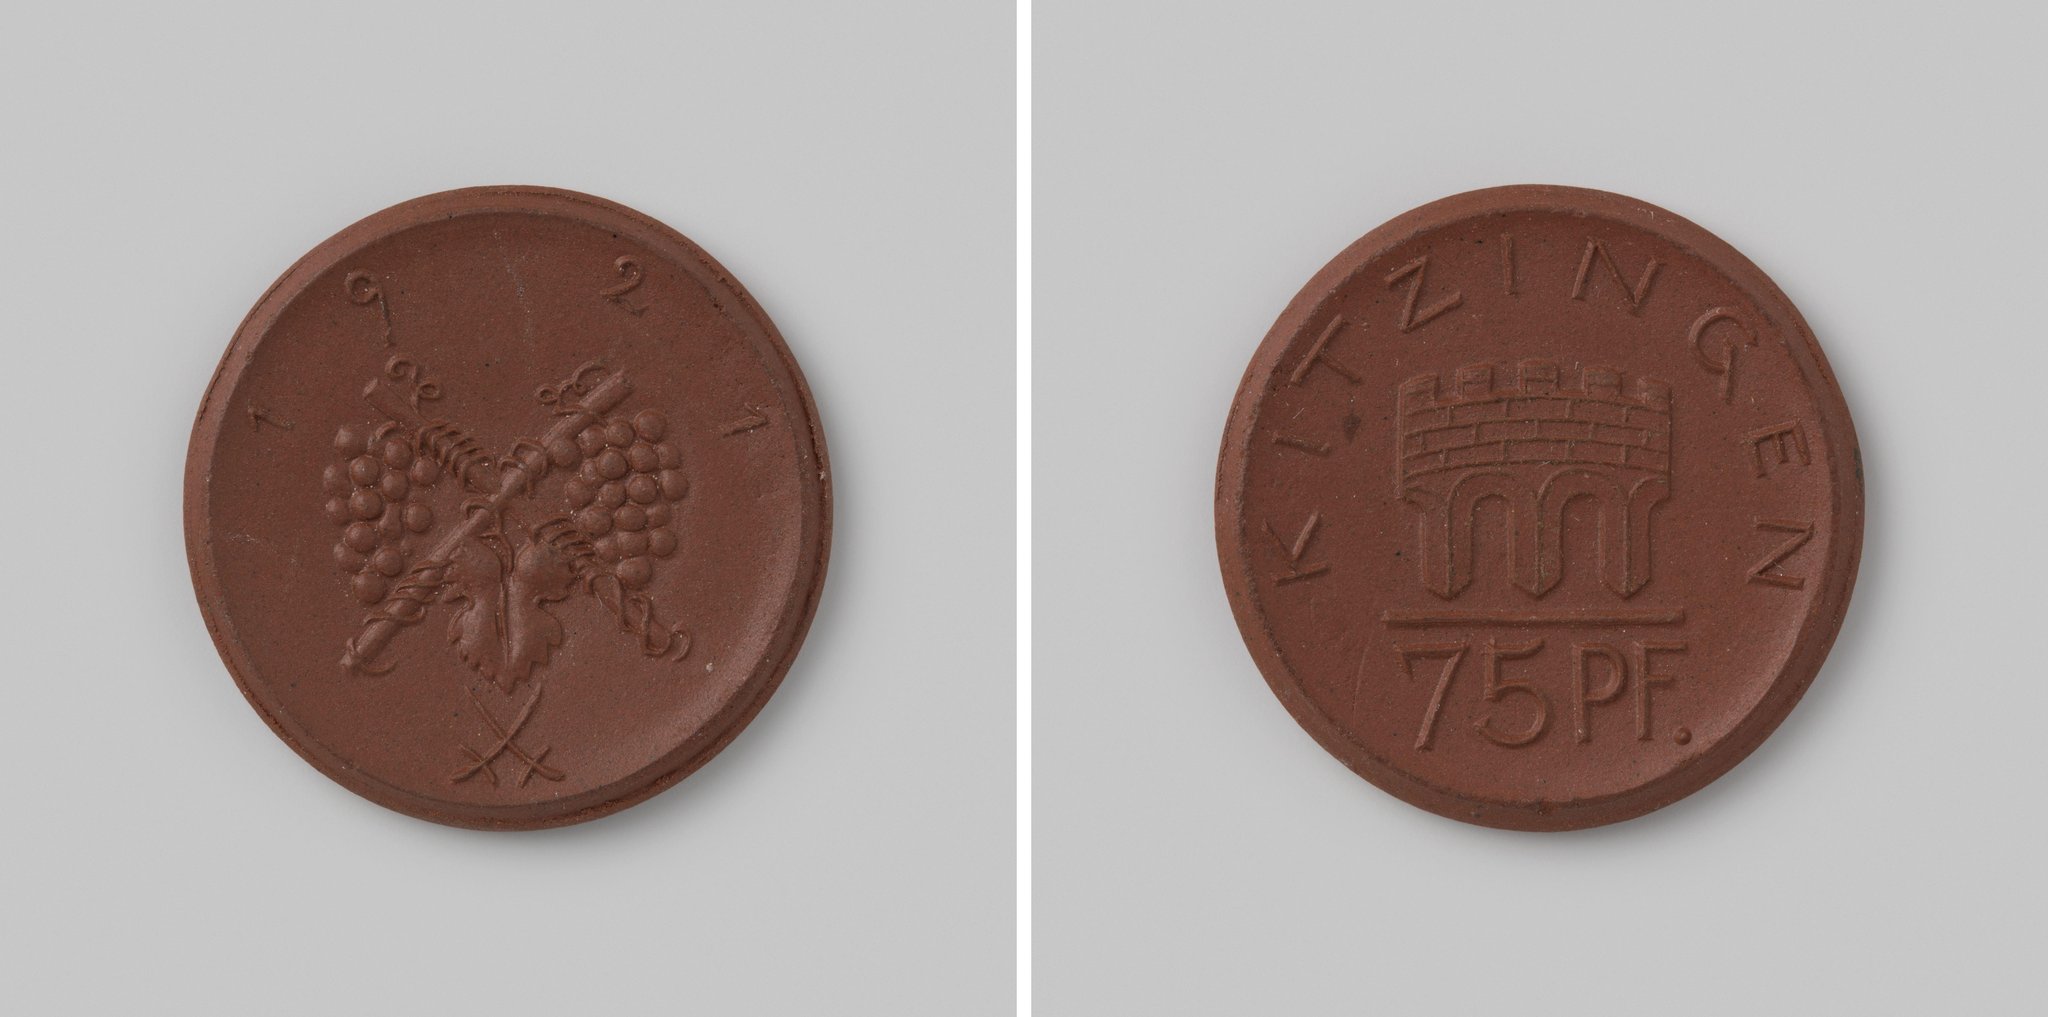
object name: coin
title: 75 pfennig uit Duitsland, Kitzingen, 1921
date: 1921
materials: porcelain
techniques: casting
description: Porseleinen pseudomunt. Voorzijde: twee gekruiste wijnranken, waarboven jaartal. Keerzijde: waarde-aanduiding in een regel, waarboven stadspoort. Daarboven plaatsaanduiding. Gladde rand.